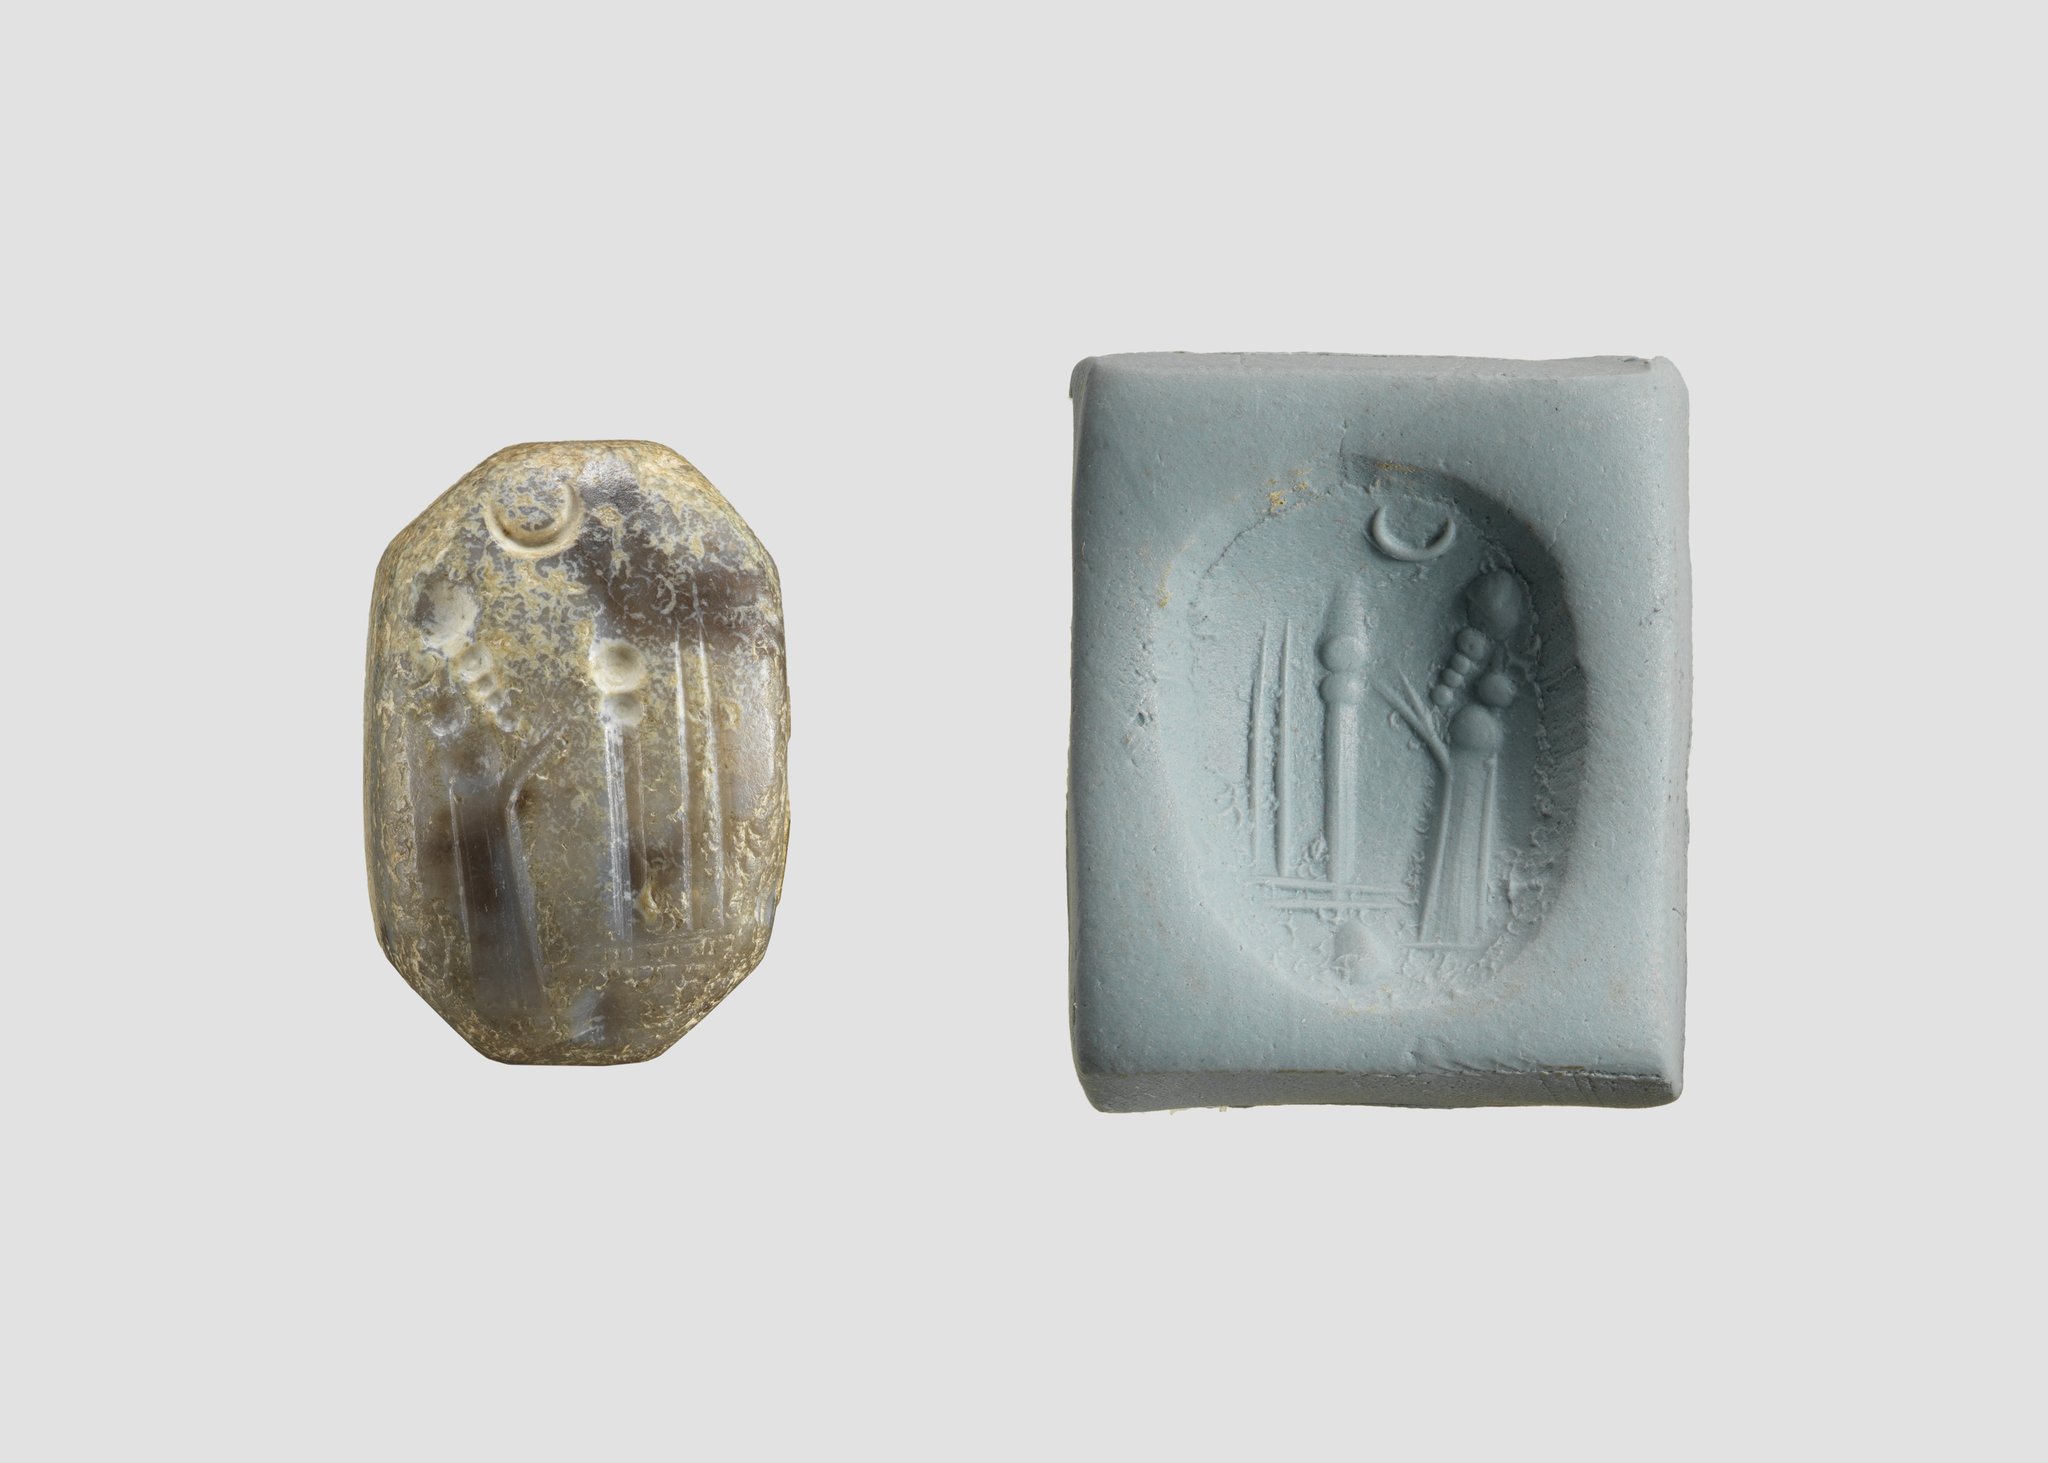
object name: stamp seal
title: Stamp seal (octagonal pyramid) with cultic scene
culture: assyro-babylonian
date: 700-501 BCE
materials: stone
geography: mesopotamia